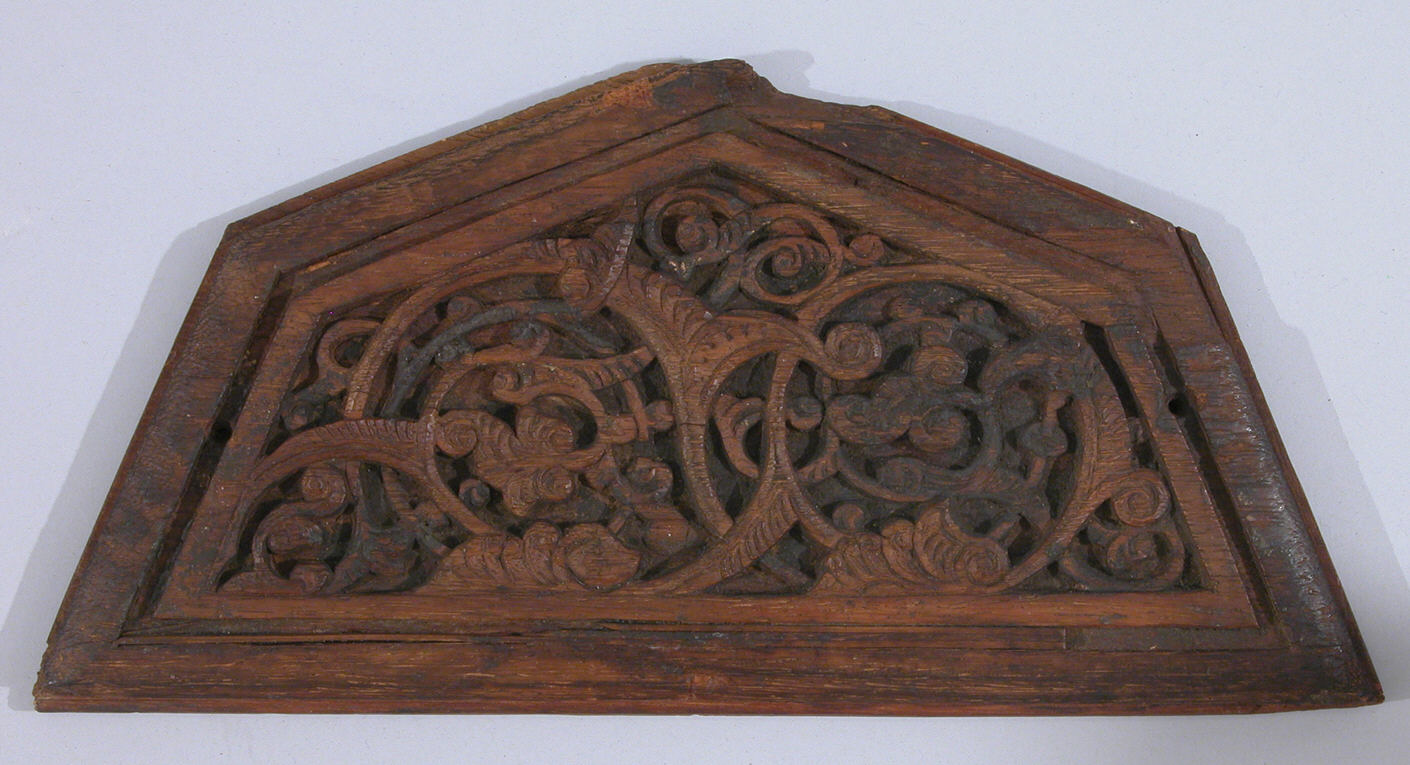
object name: panel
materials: wood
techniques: carving, inlay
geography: egypt